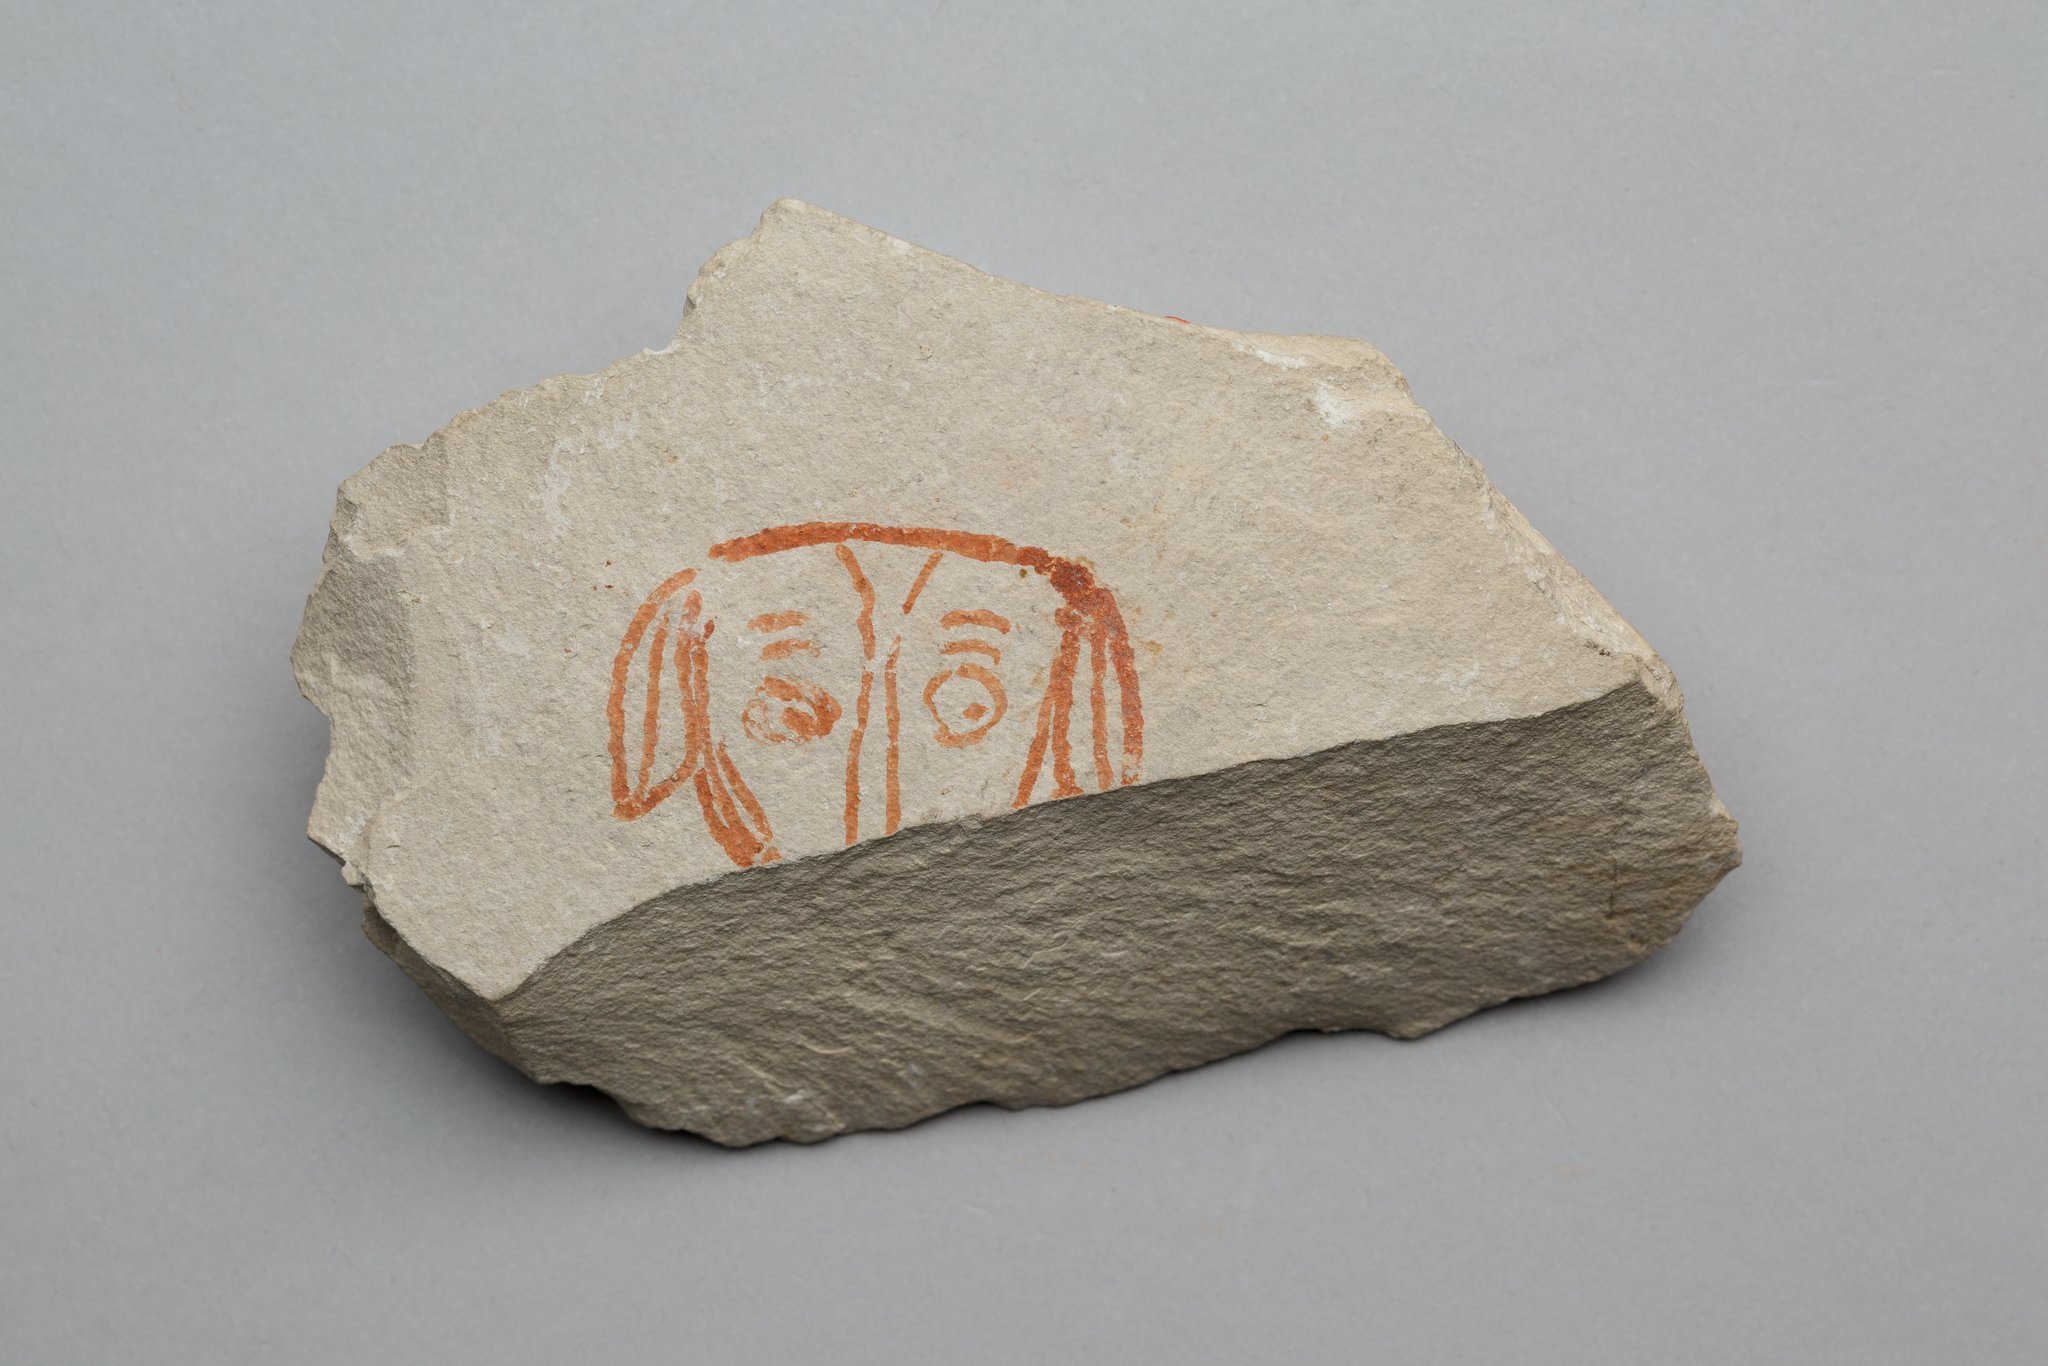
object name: ostracon, figured, dog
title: Sketch of a dog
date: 1295-1070 BCE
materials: ink, limestone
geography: egypt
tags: dogs